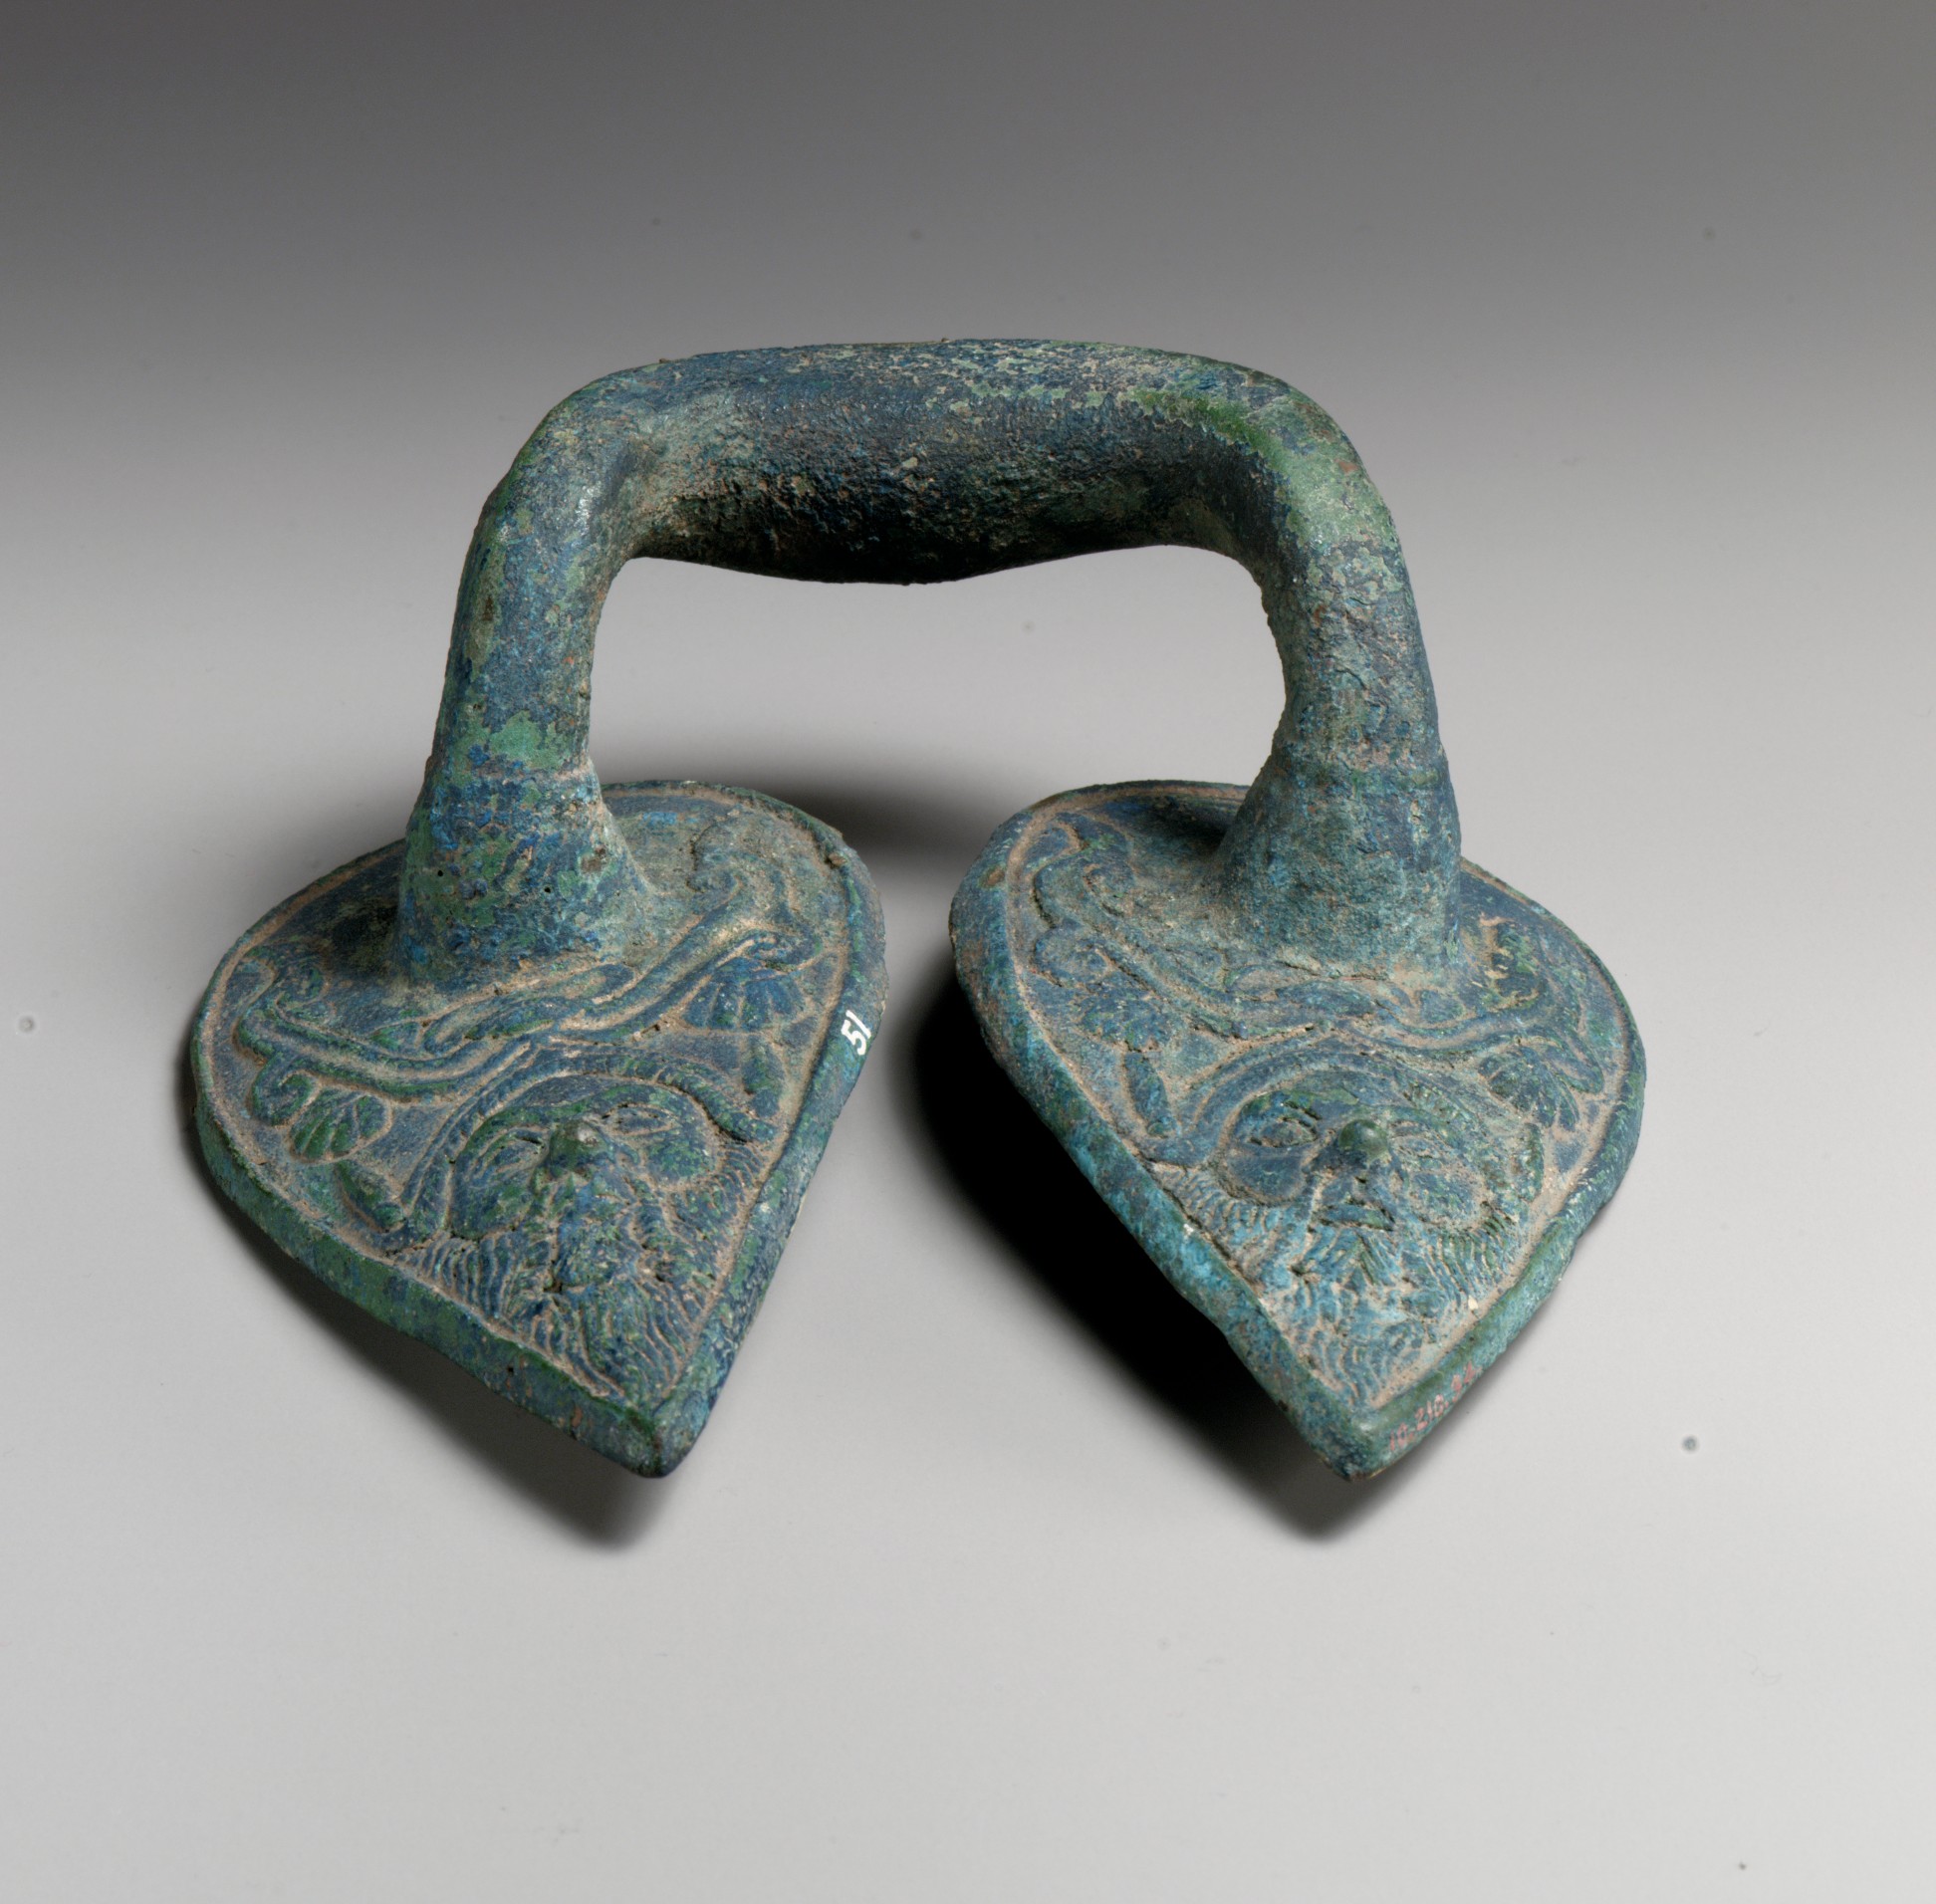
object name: handle with silenos mask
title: Bronze handle of a vessel with Silenos mask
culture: etruscan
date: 450-400 BCE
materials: bronze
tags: masks